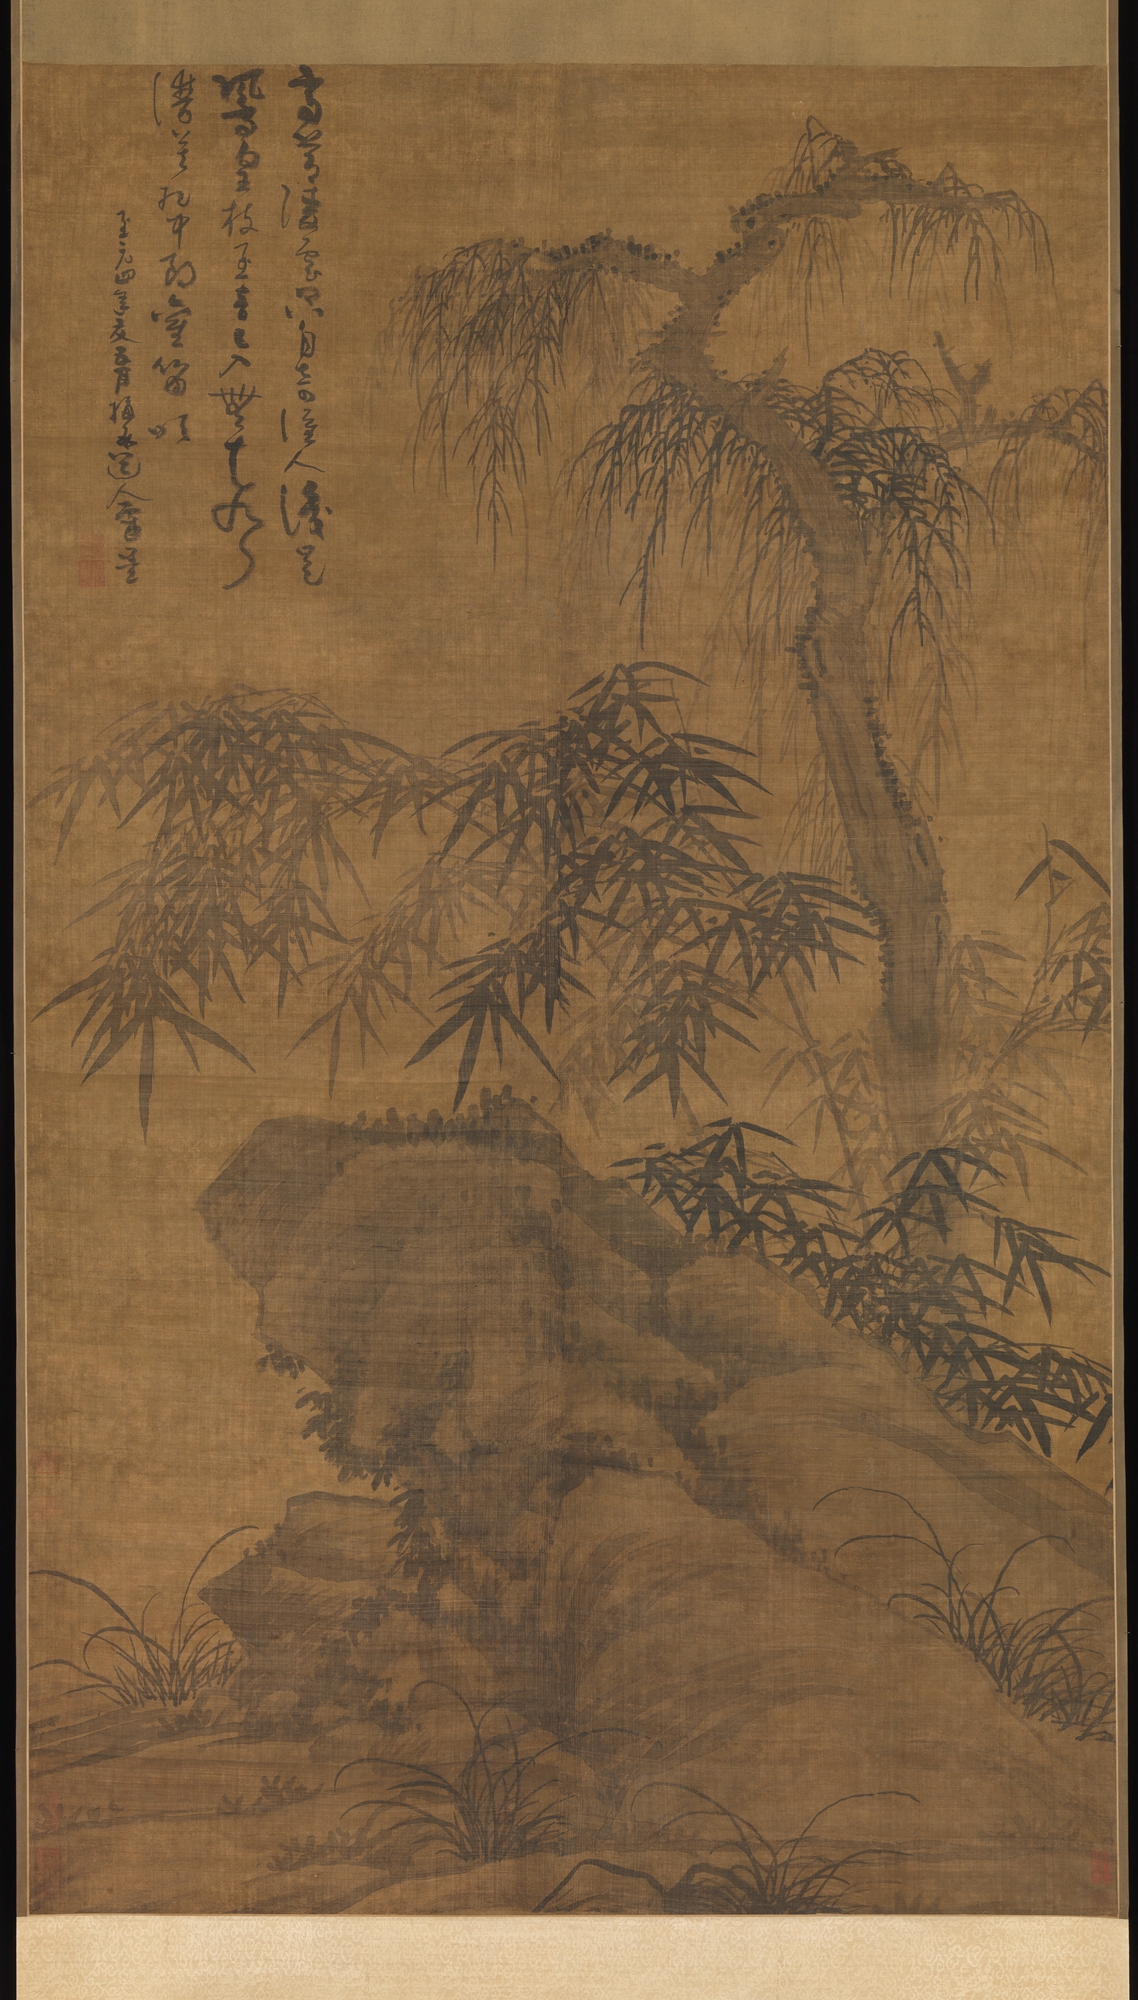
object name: hanging scroll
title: Bamboo, old tree, and rock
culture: chinese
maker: wu zhen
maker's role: artist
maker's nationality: chinese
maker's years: 1280-1354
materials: ink, silk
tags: bamboo